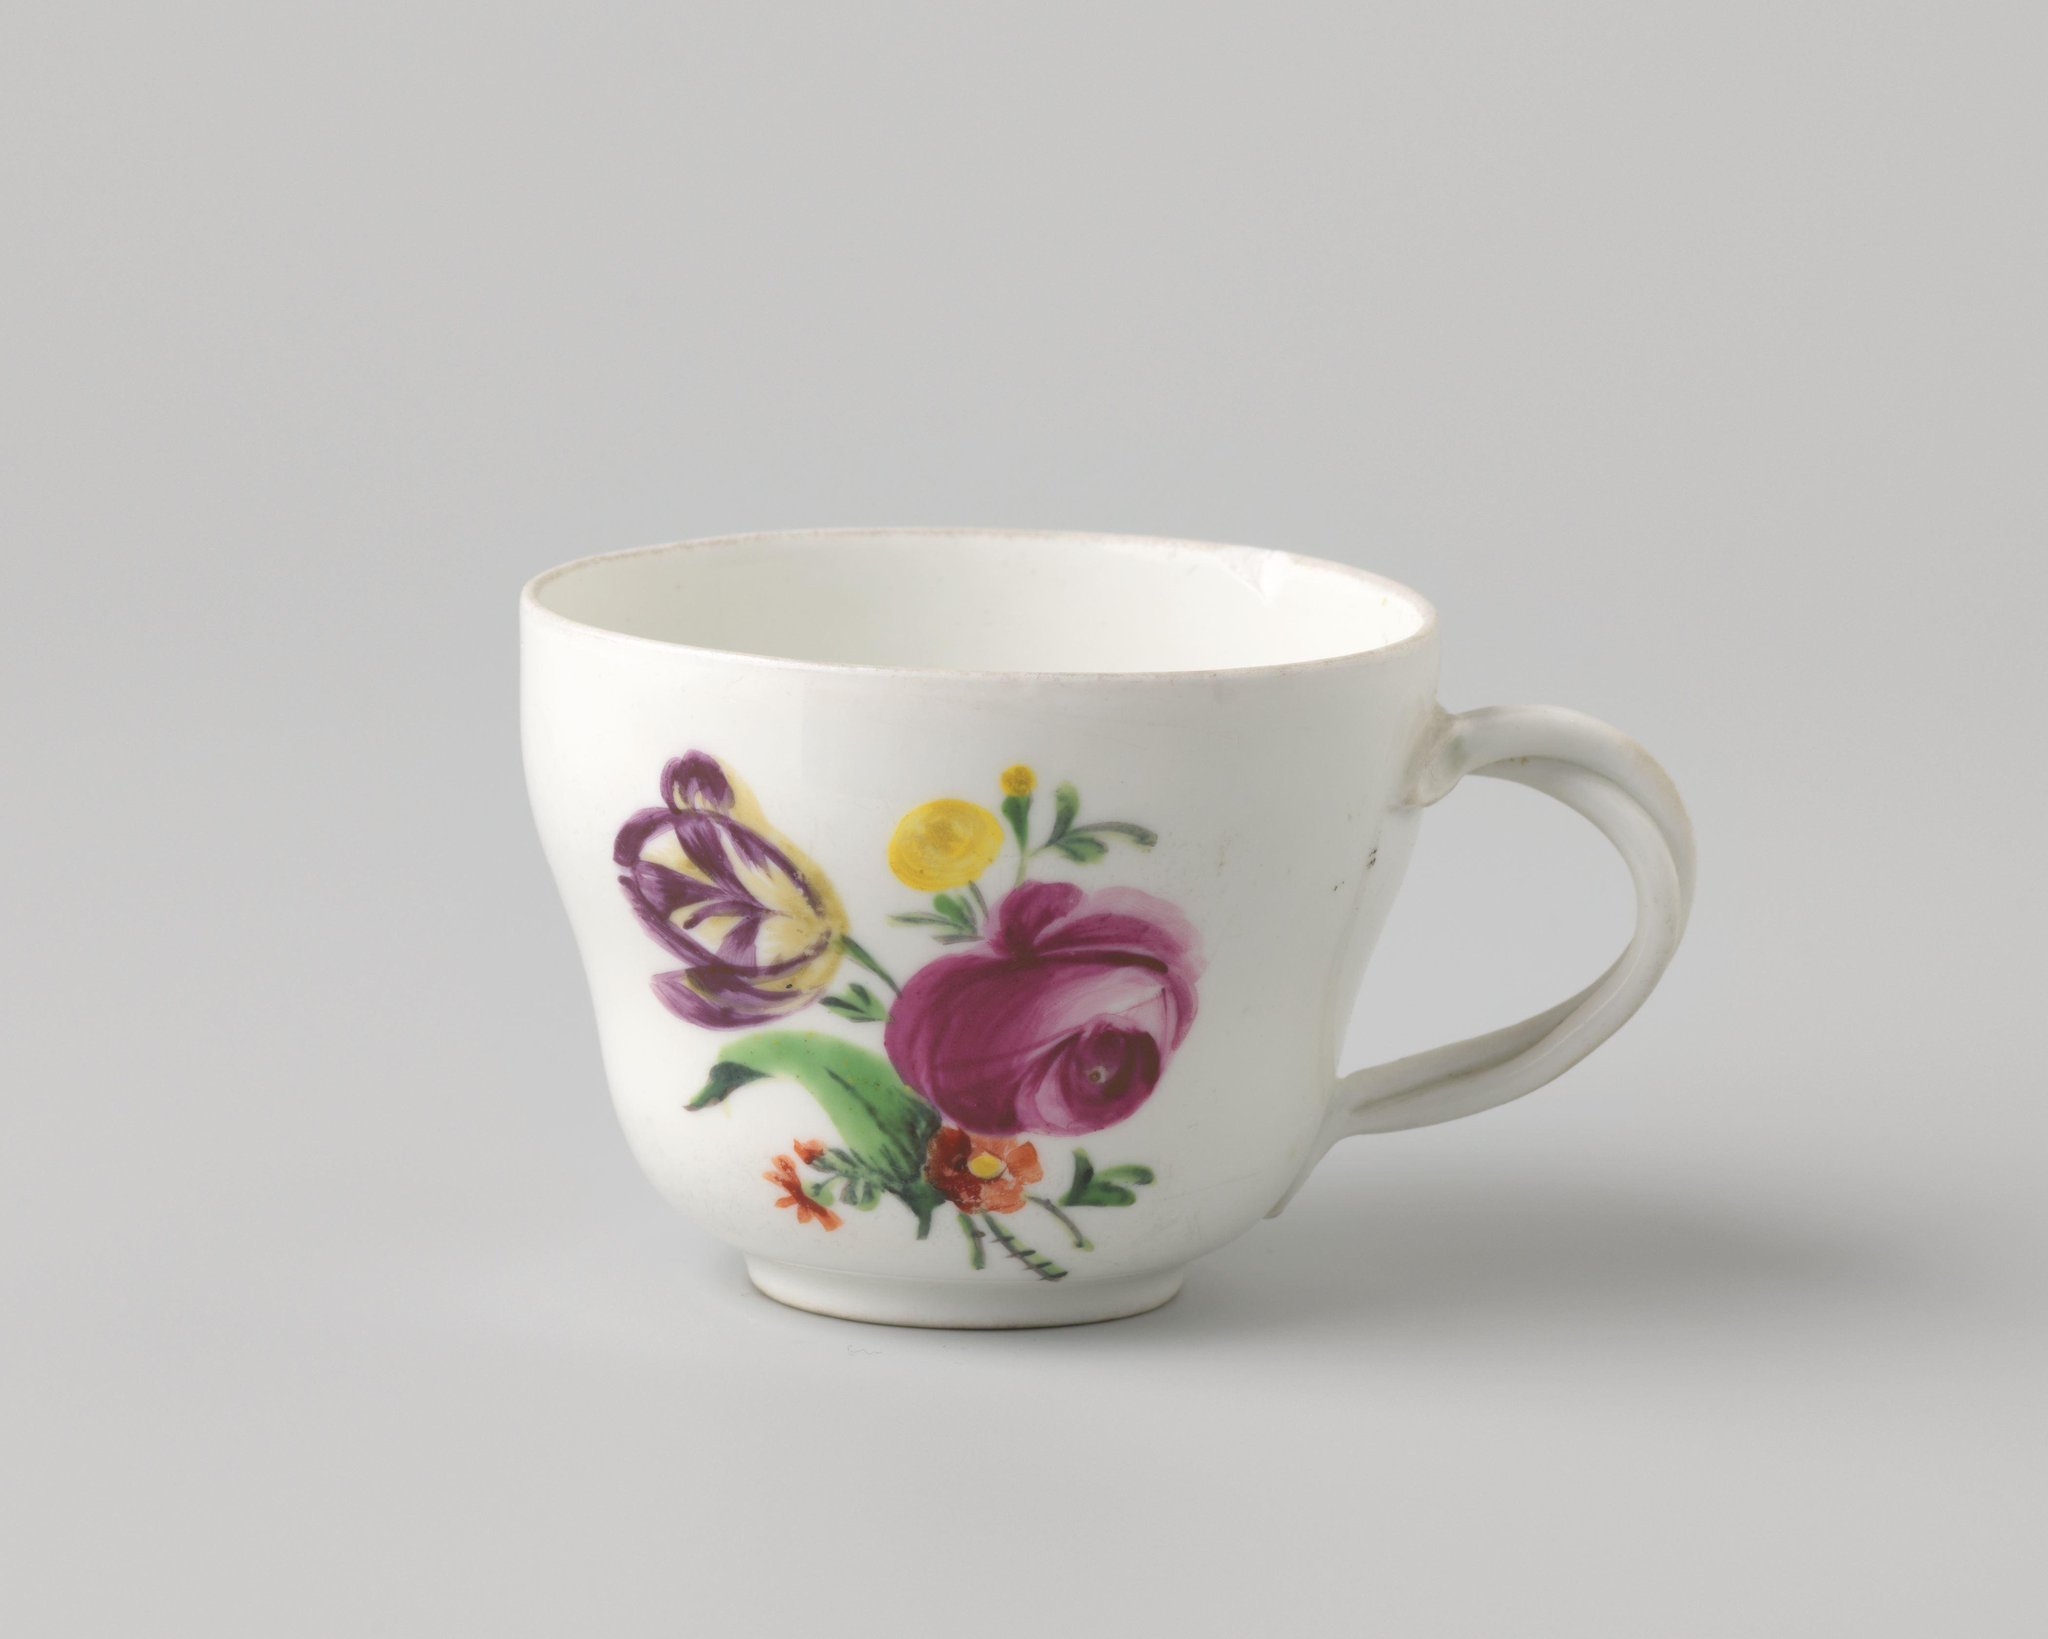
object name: service set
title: Cup with a bouquet and flower sprays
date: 1800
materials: glaze, paint, porcelain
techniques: firing, forming, turning, vitrification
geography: vienna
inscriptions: mark: ‘schild/ 9/ 800’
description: Kop, onderdeel van een servies beschilderd met veelkleurige bloemboeketten en strooibloemen. Aan het kopje een oor in de vorm van twee verstrengelde takken. Merken niet voor alle koppen gelijk (bk-1956-63-24/33): o.a. in paars de getallen 83 en 43 en ingegrift de getallen 39 en 800; in onderglazuur blauw een schild met twee dwarsbalken.